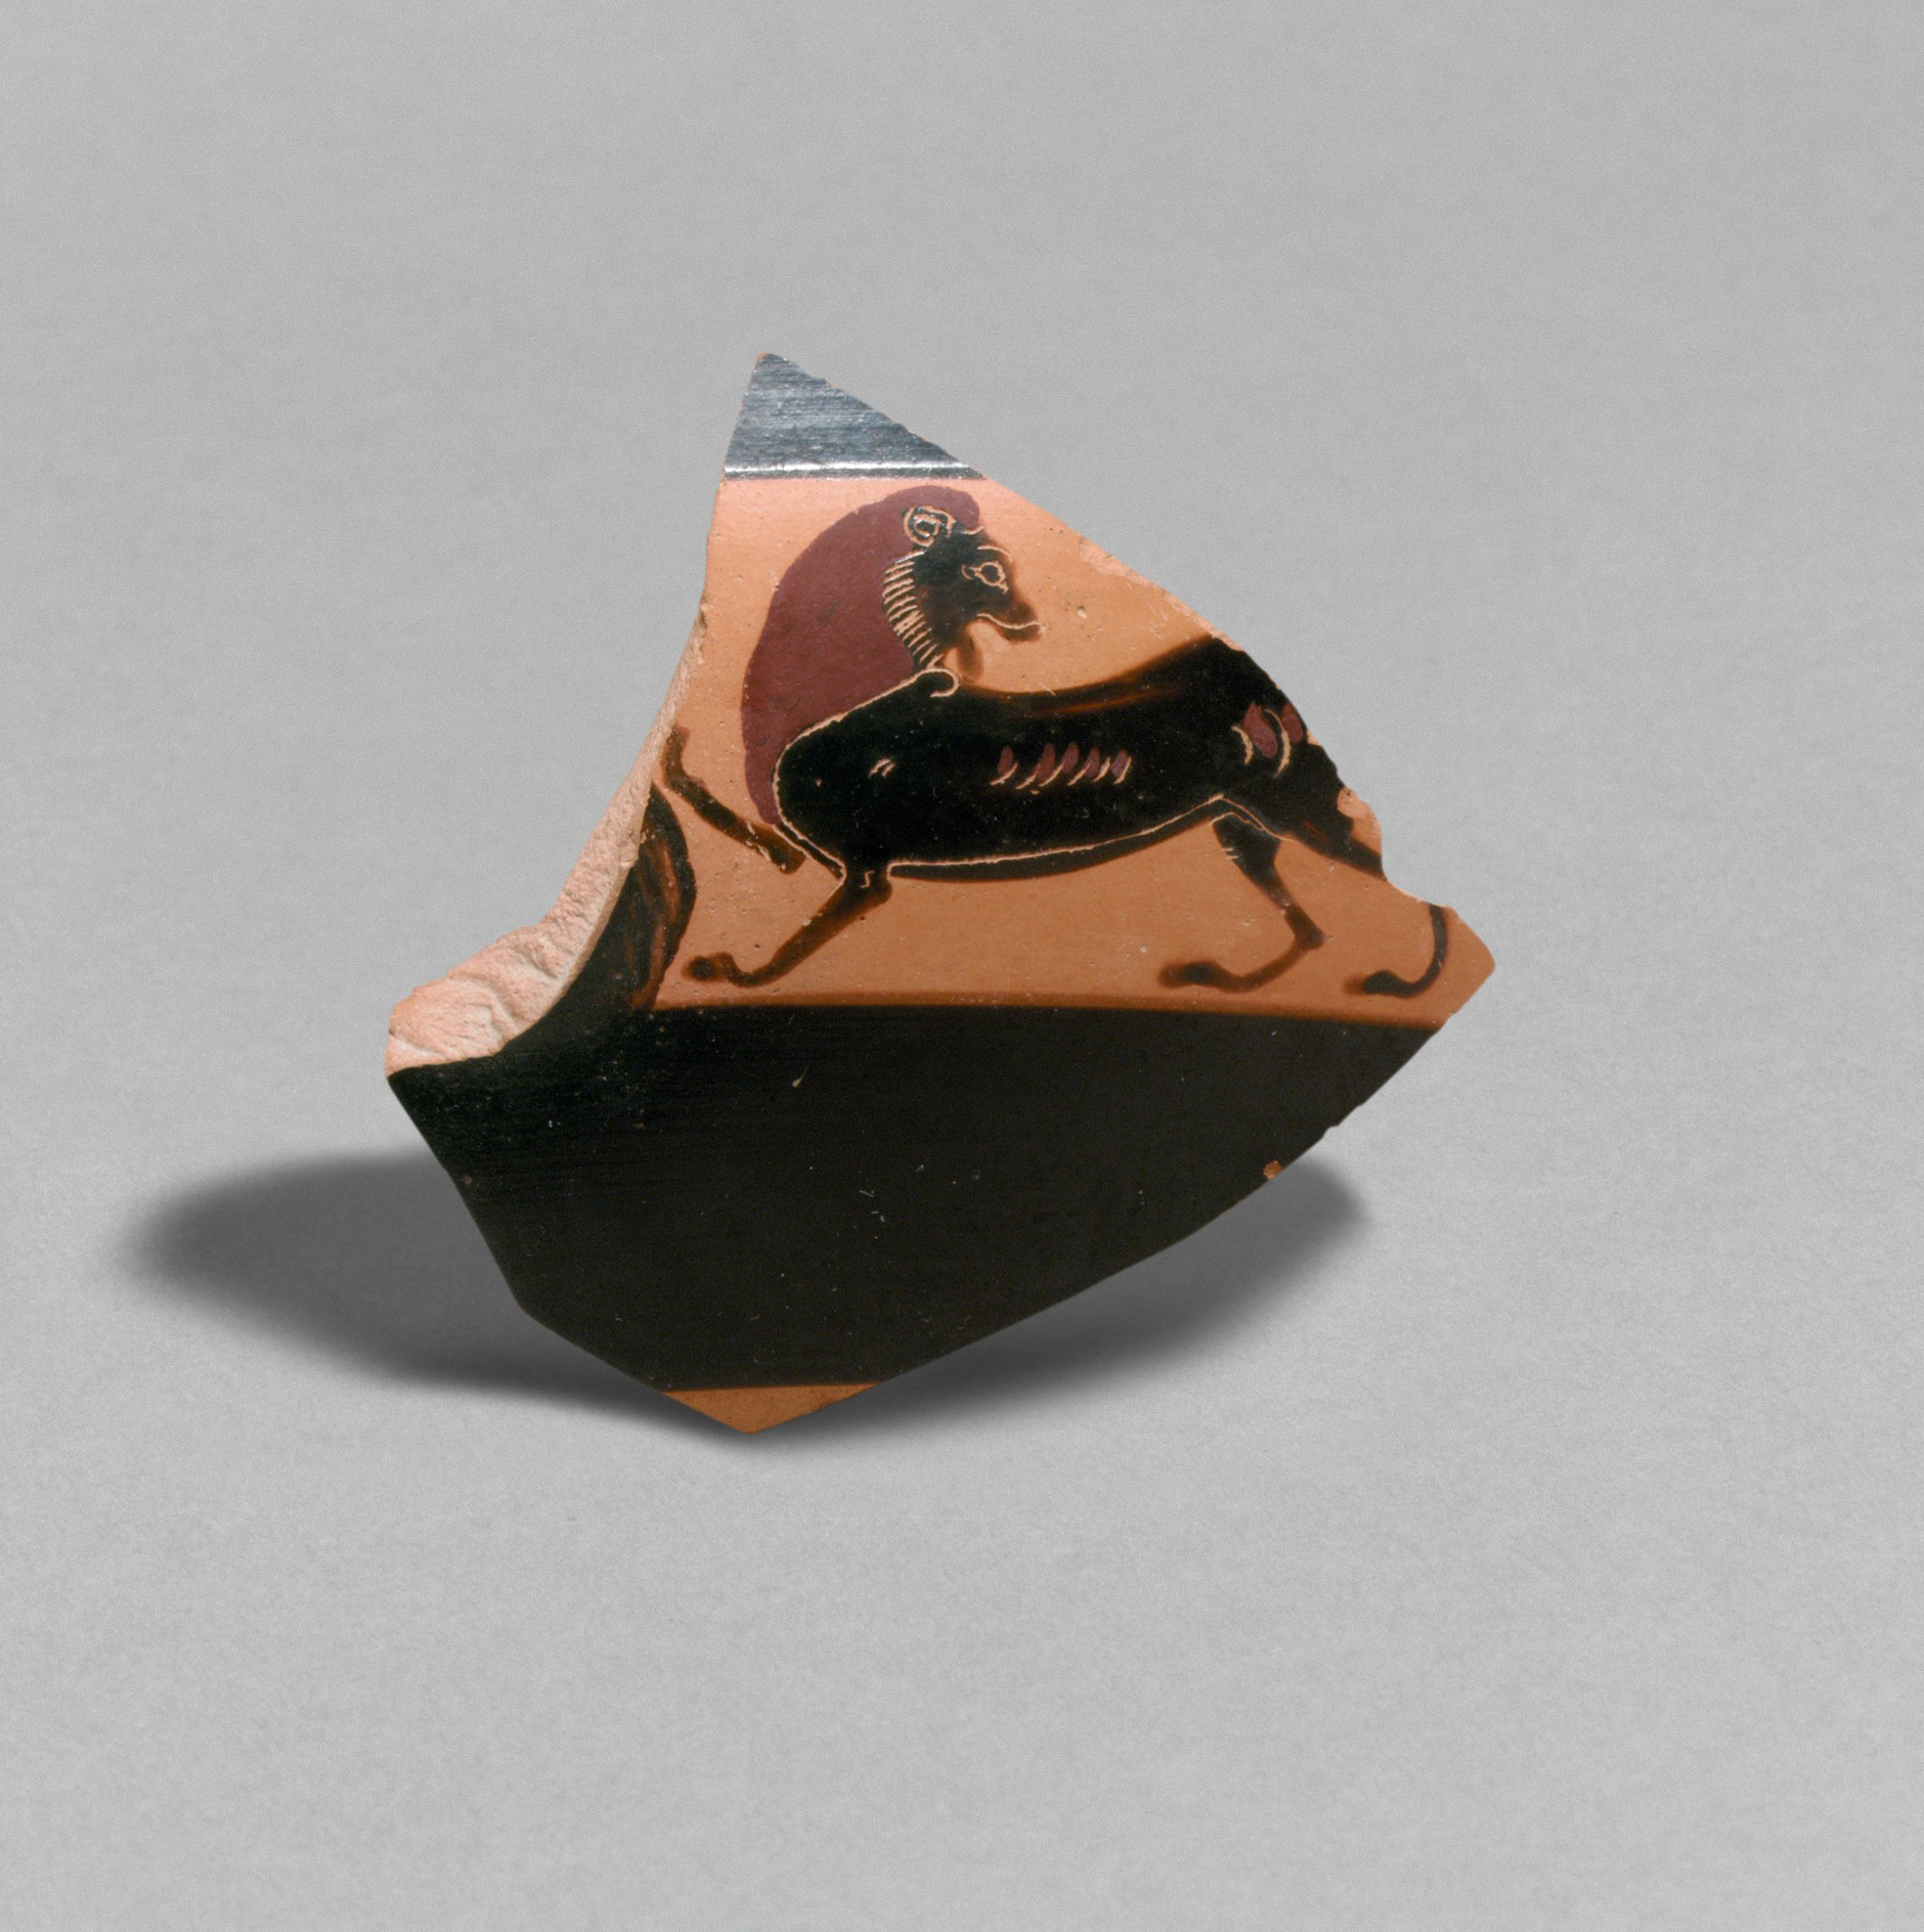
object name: kylix, band cup fragment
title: Fragment of a terracotta kylix: band-cup (drinking cup)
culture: greek, attic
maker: amasis painter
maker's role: artist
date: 550 BCE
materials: terracotta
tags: lions